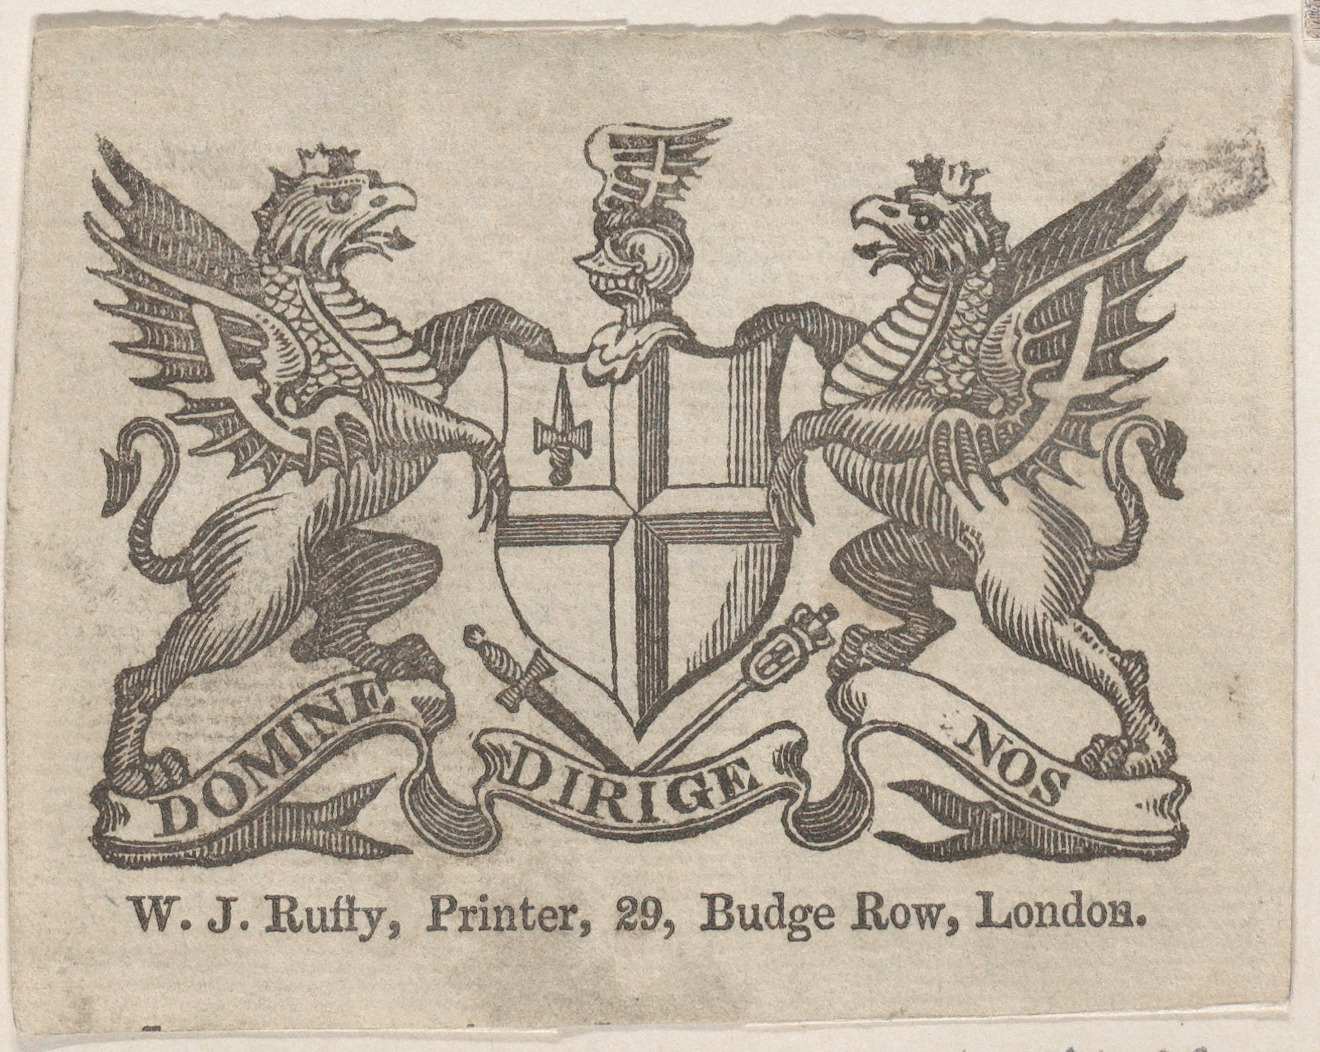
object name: print, trade card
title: Trade Card for Jones and Barriff, Engravers and Printers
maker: anonymous, british, 19th century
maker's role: artist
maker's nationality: british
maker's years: 1800-1900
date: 1801-1900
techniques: engraving